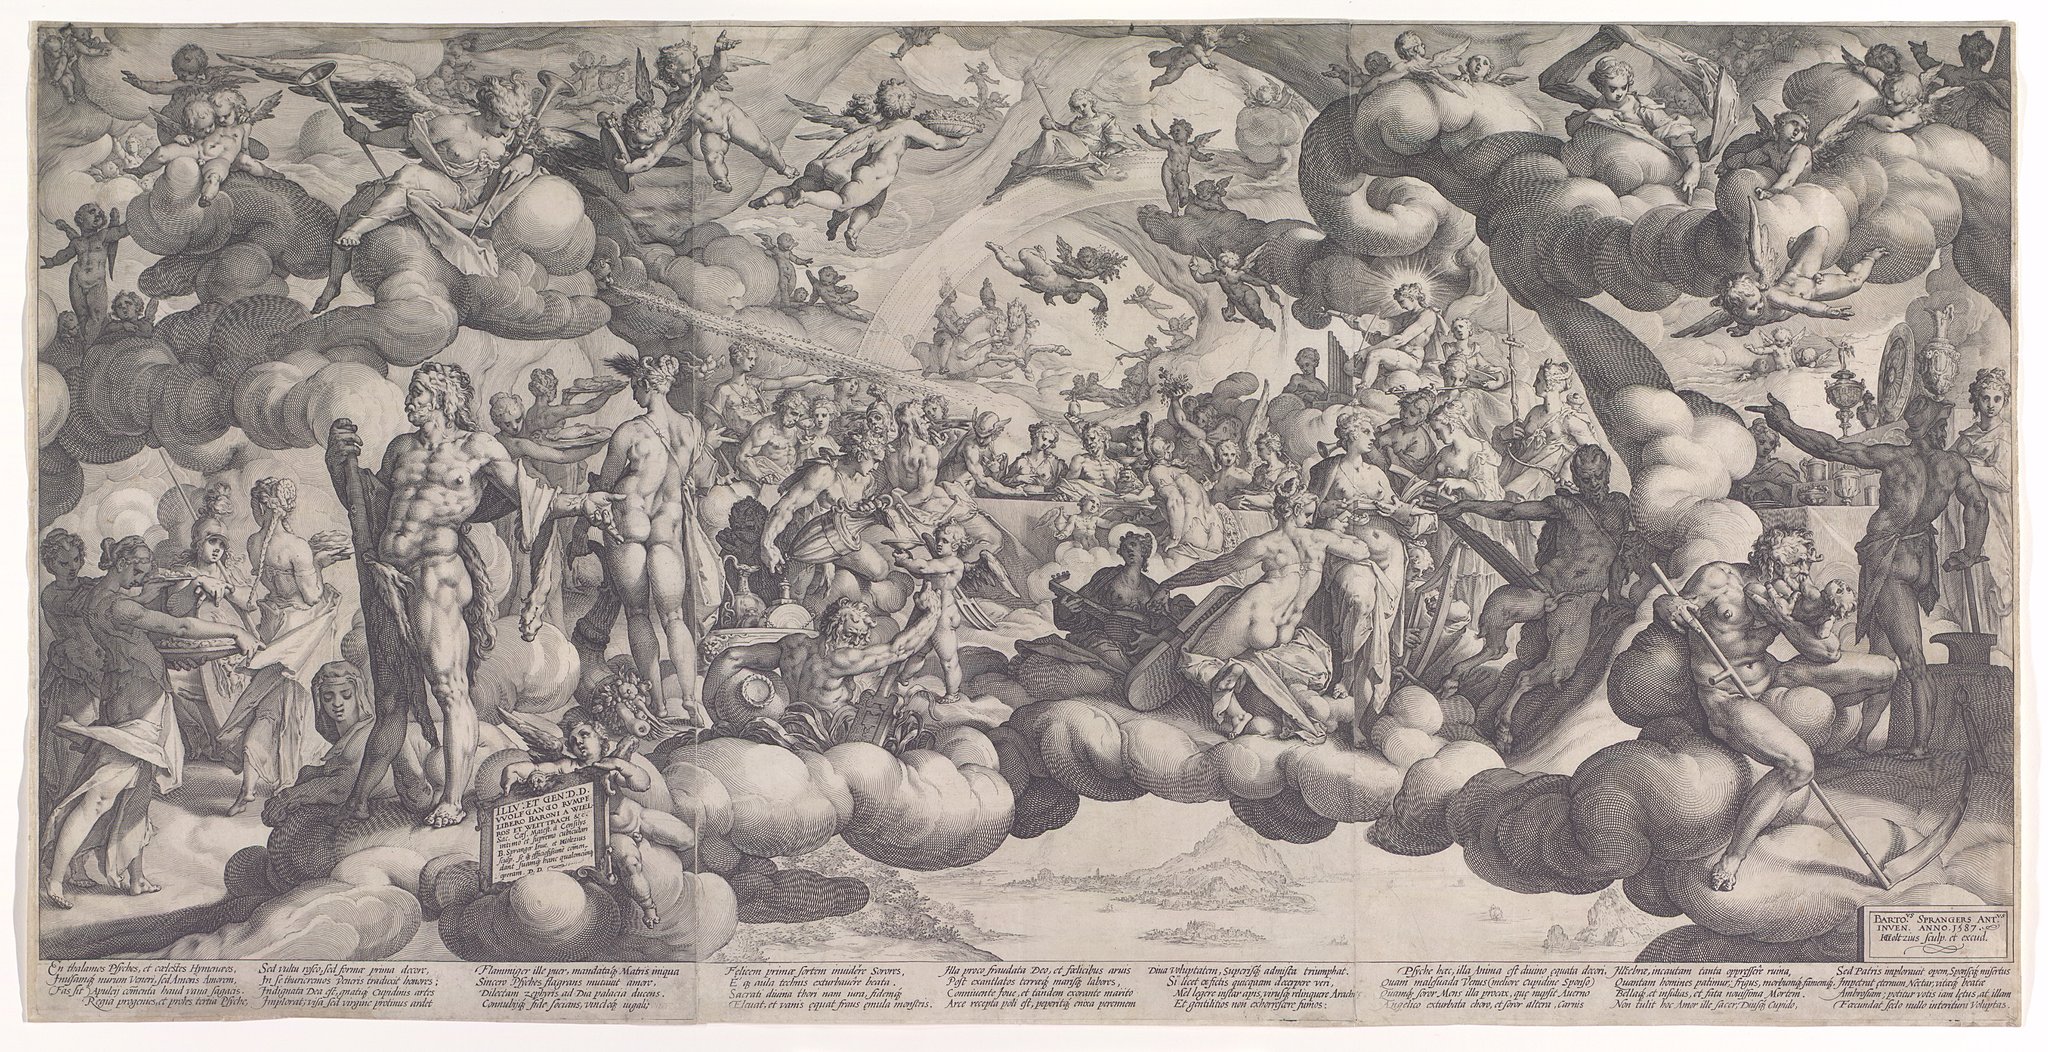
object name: print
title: The Feast of the Gods at the Marriage of Cupid and Psyche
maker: hendrick goltzius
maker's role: artist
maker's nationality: netherlandish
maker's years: 1558-1617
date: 1587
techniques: engraving, printing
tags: cupid,psyche,satyrs